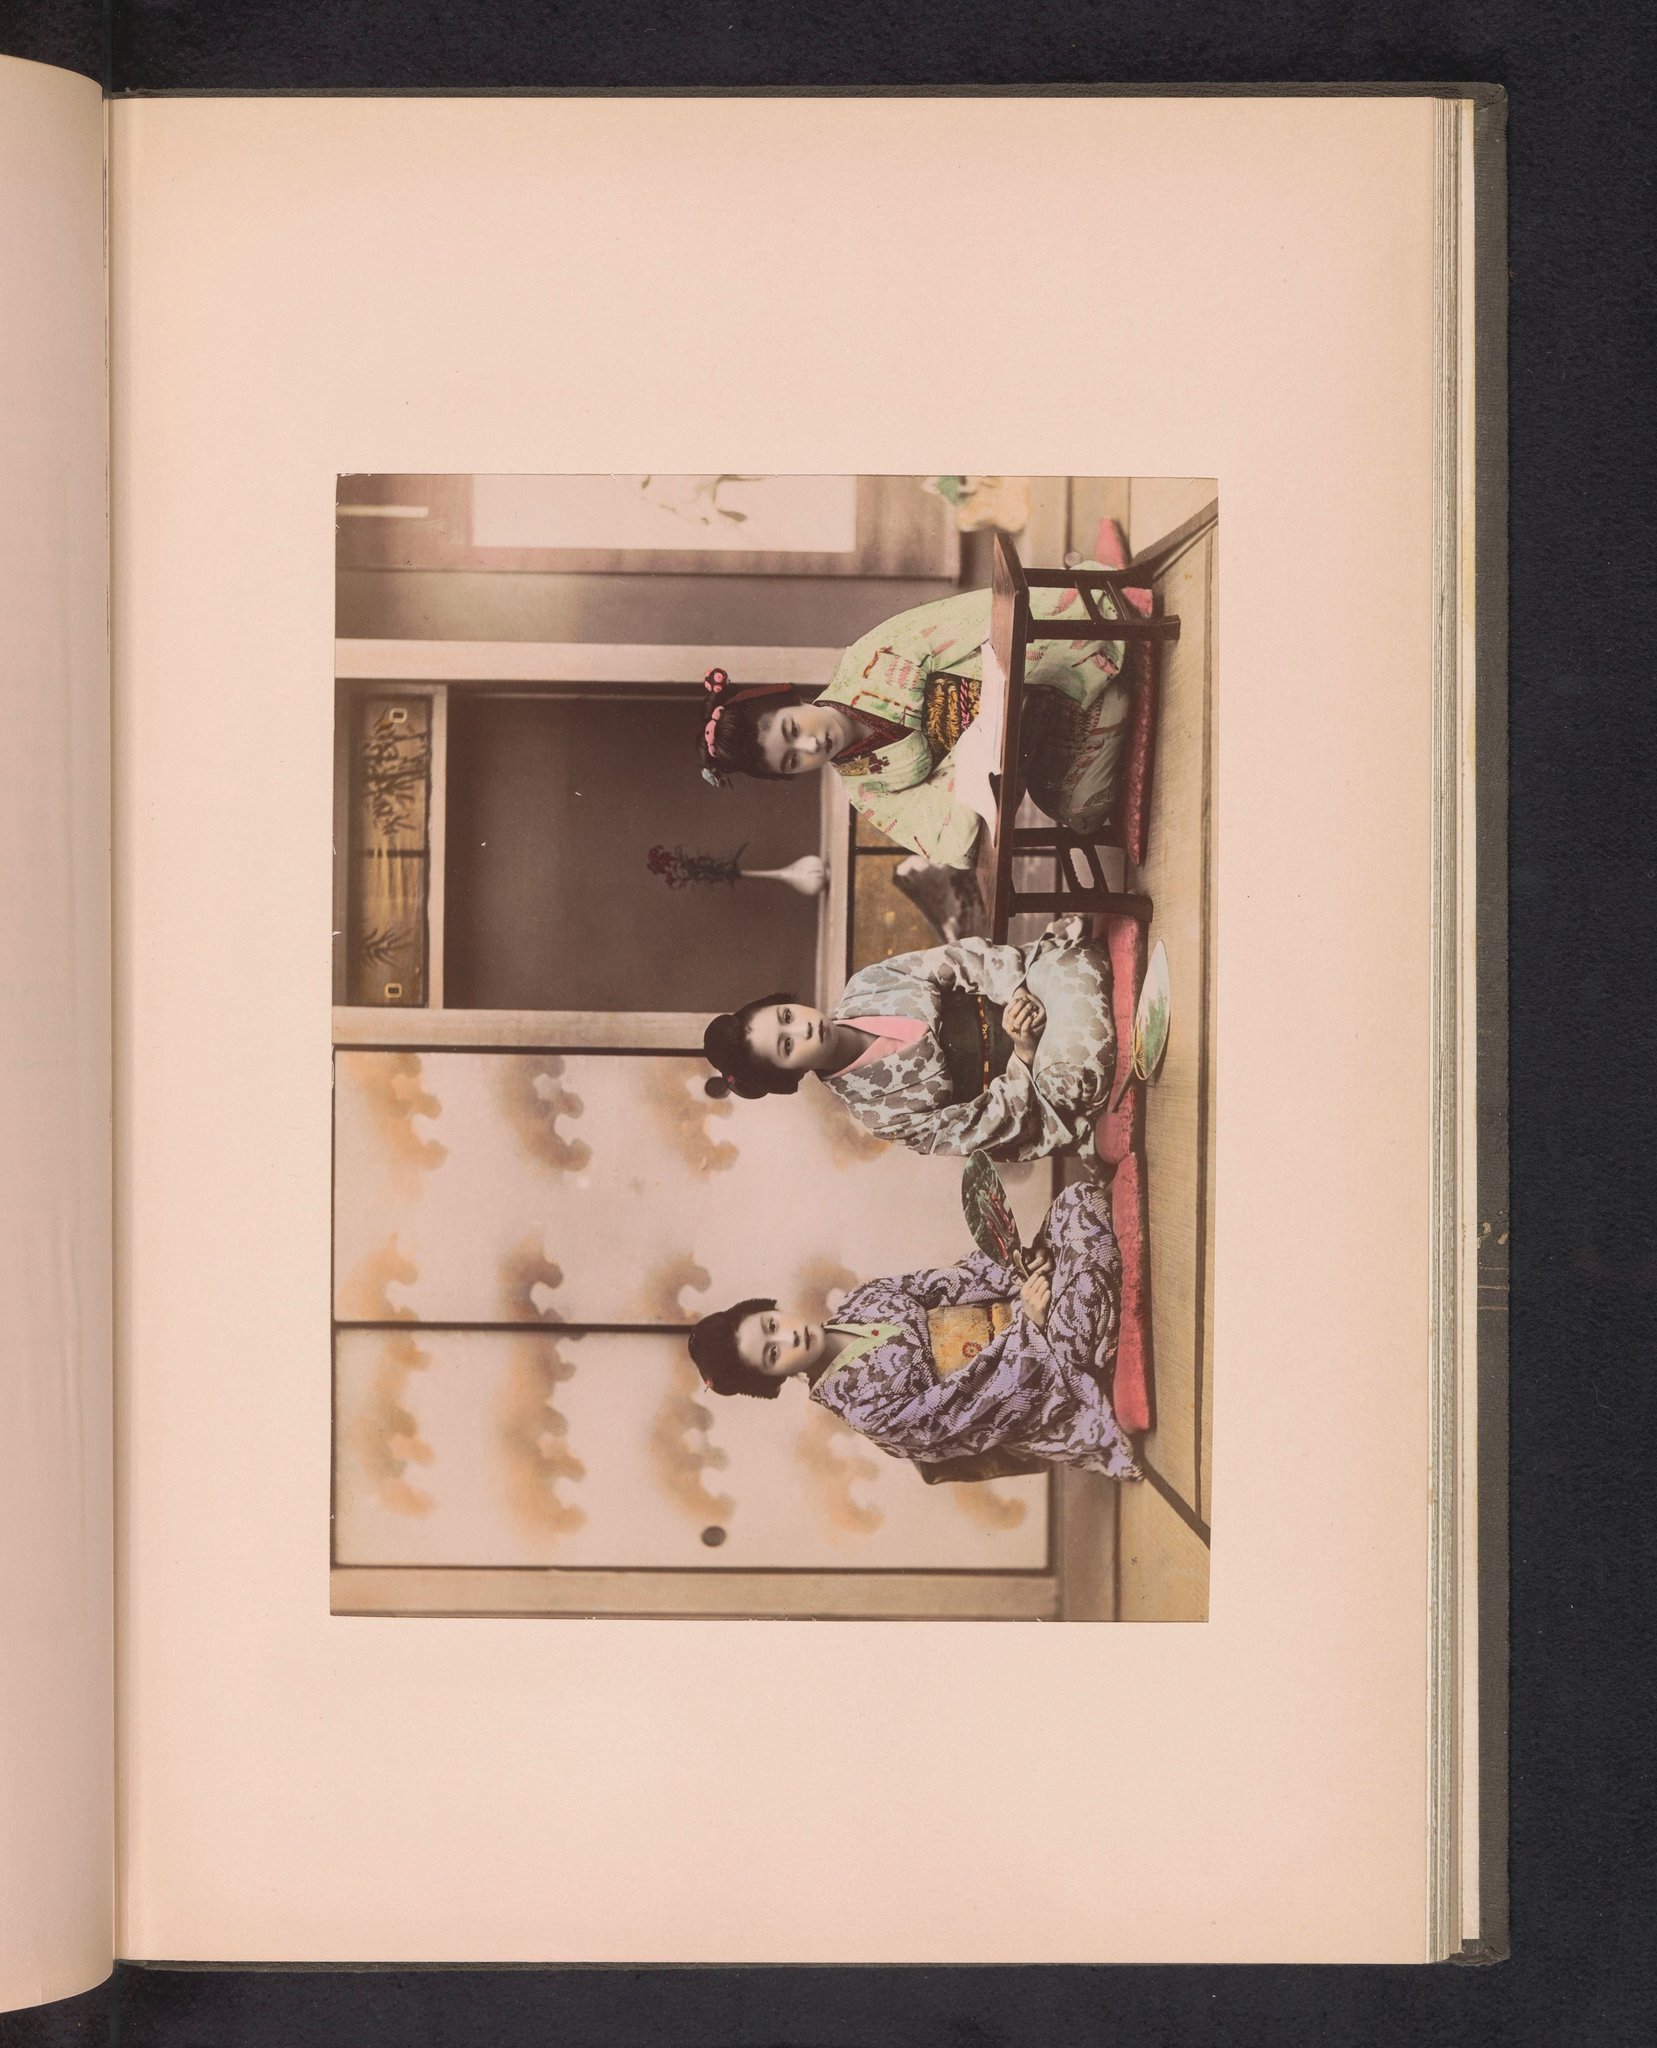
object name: page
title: Drie zittende geisha's in een interieur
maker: Anonymous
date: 1887-1897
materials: photographic support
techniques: albumen print, hand coloring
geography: japan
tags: adolescent, young woman, maiden, fan, interior ~ representation of a building